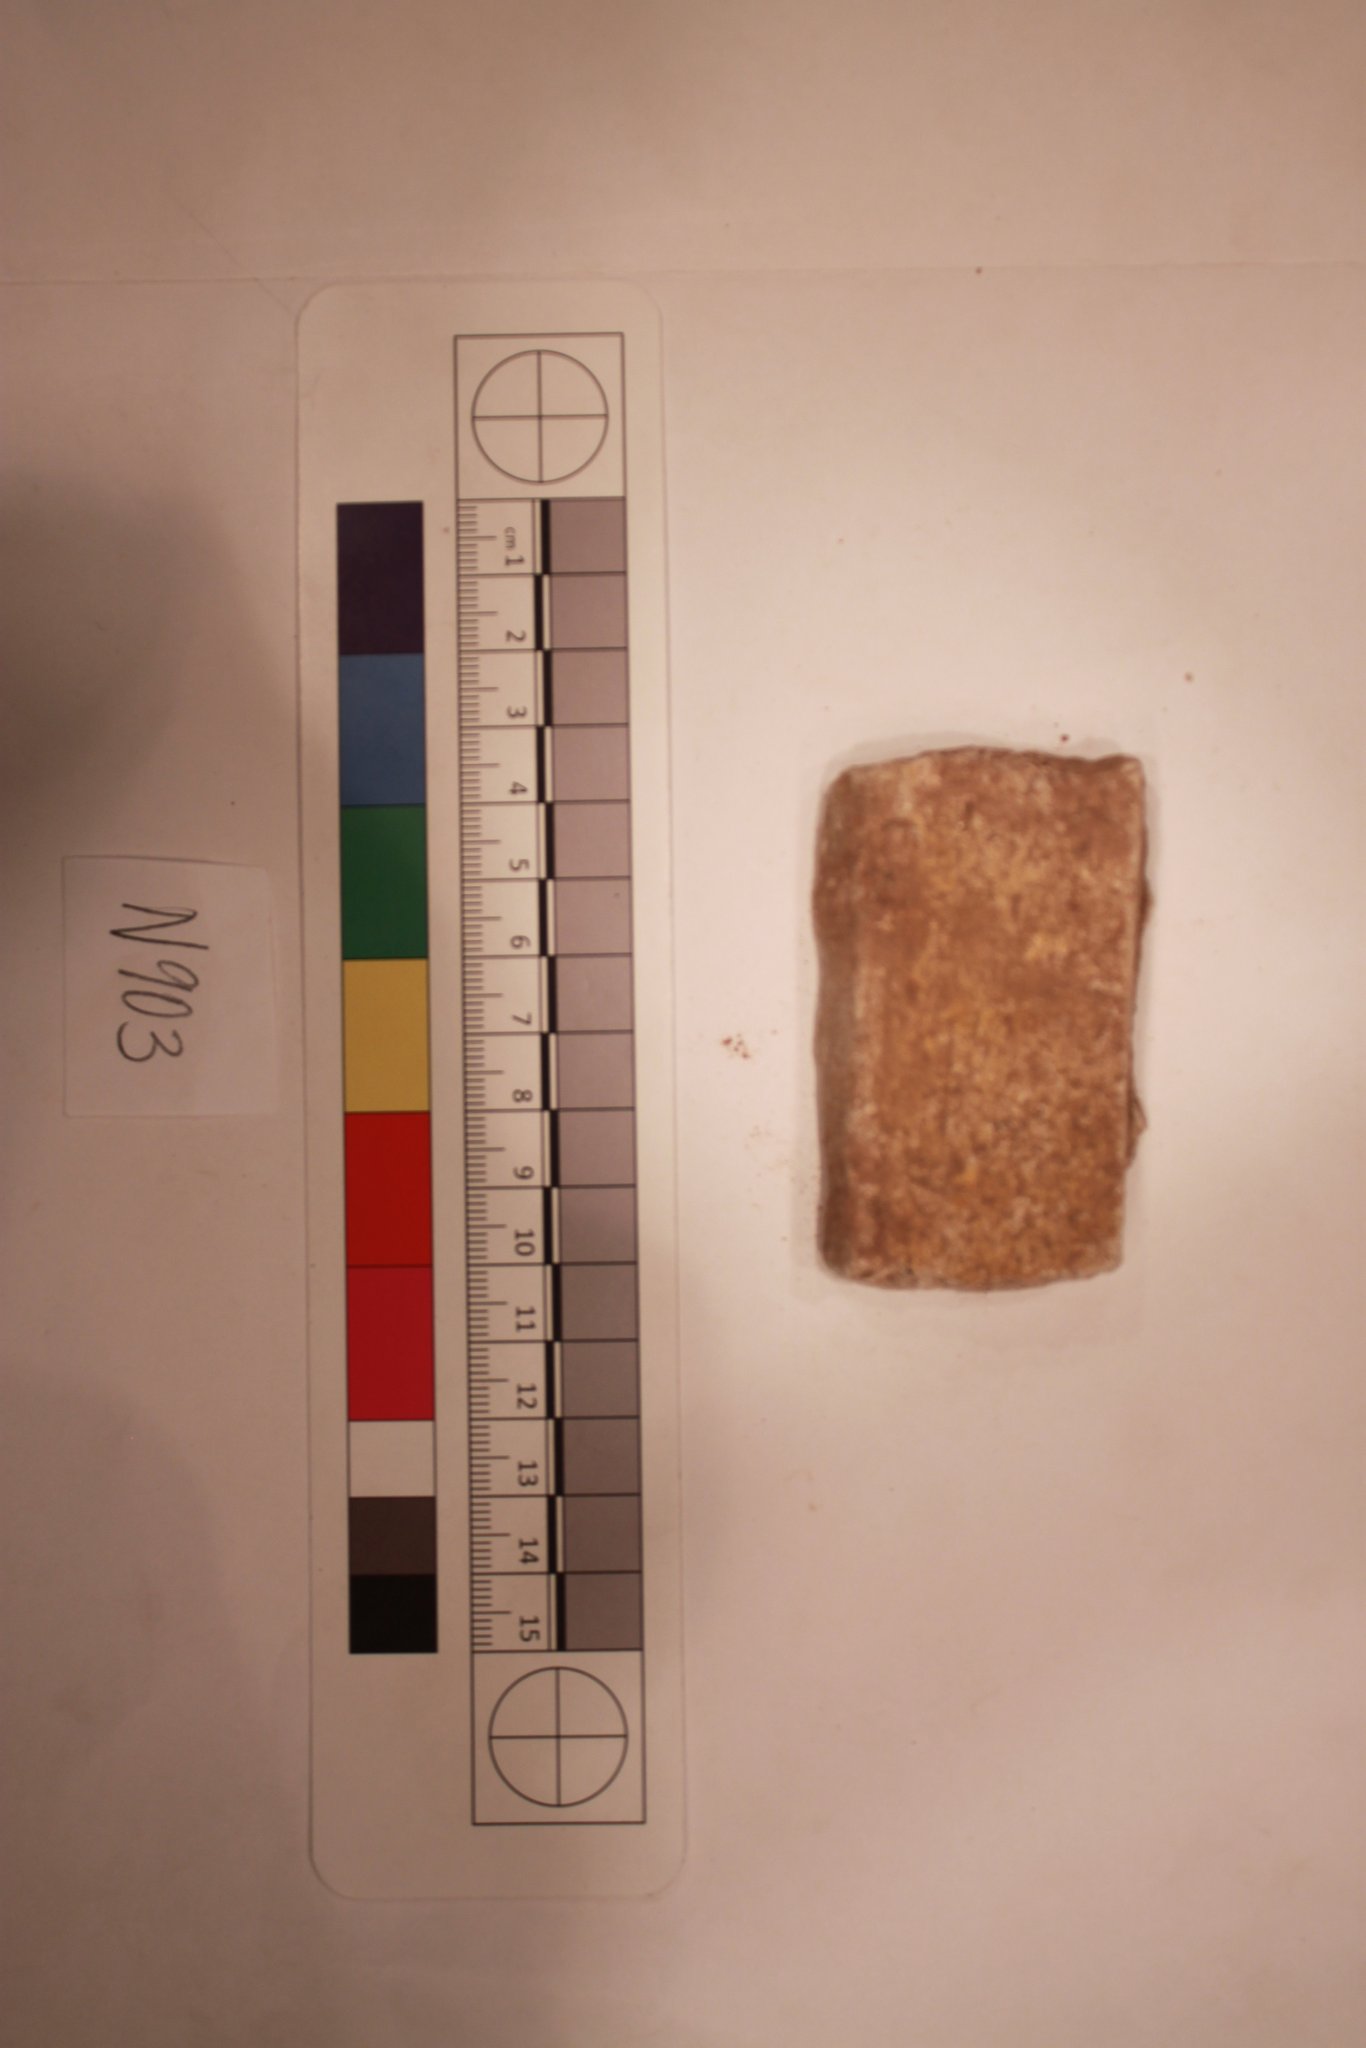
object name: fragment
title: Stucco Fragment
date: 701-1200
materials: plaster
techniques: carving, painting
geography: iran